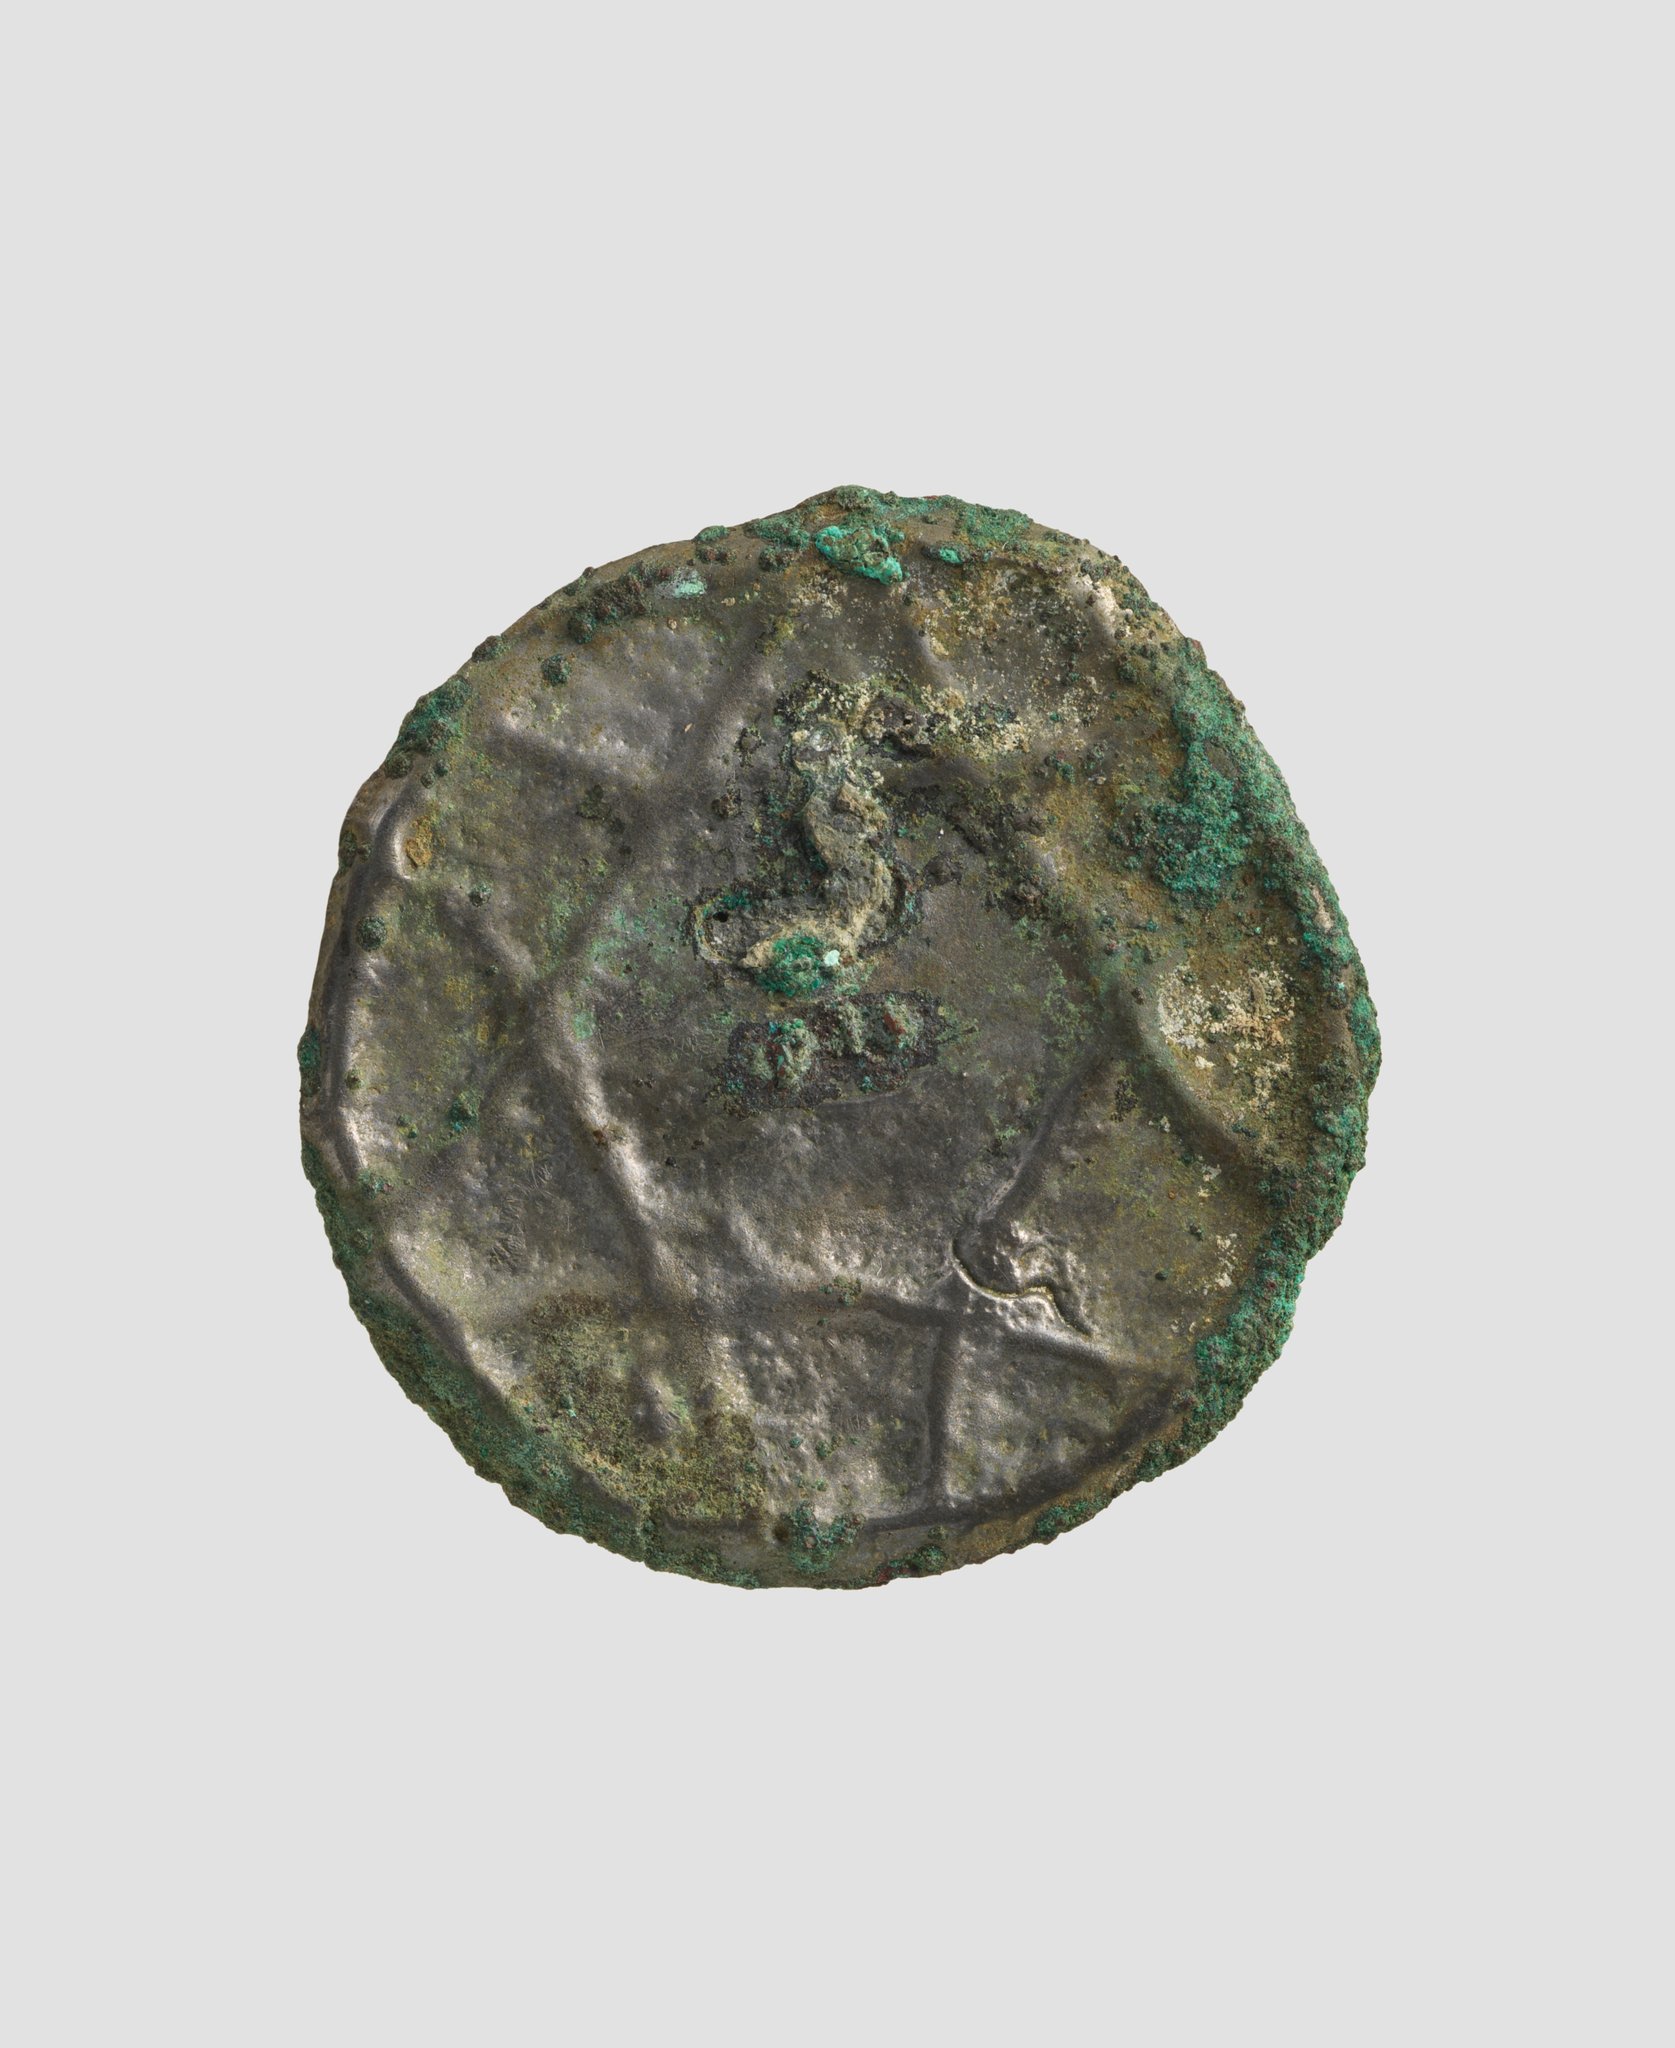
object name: mirror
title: Pocket-sized bronze mirror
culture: alanic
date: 601-900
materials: metal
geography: caucasus